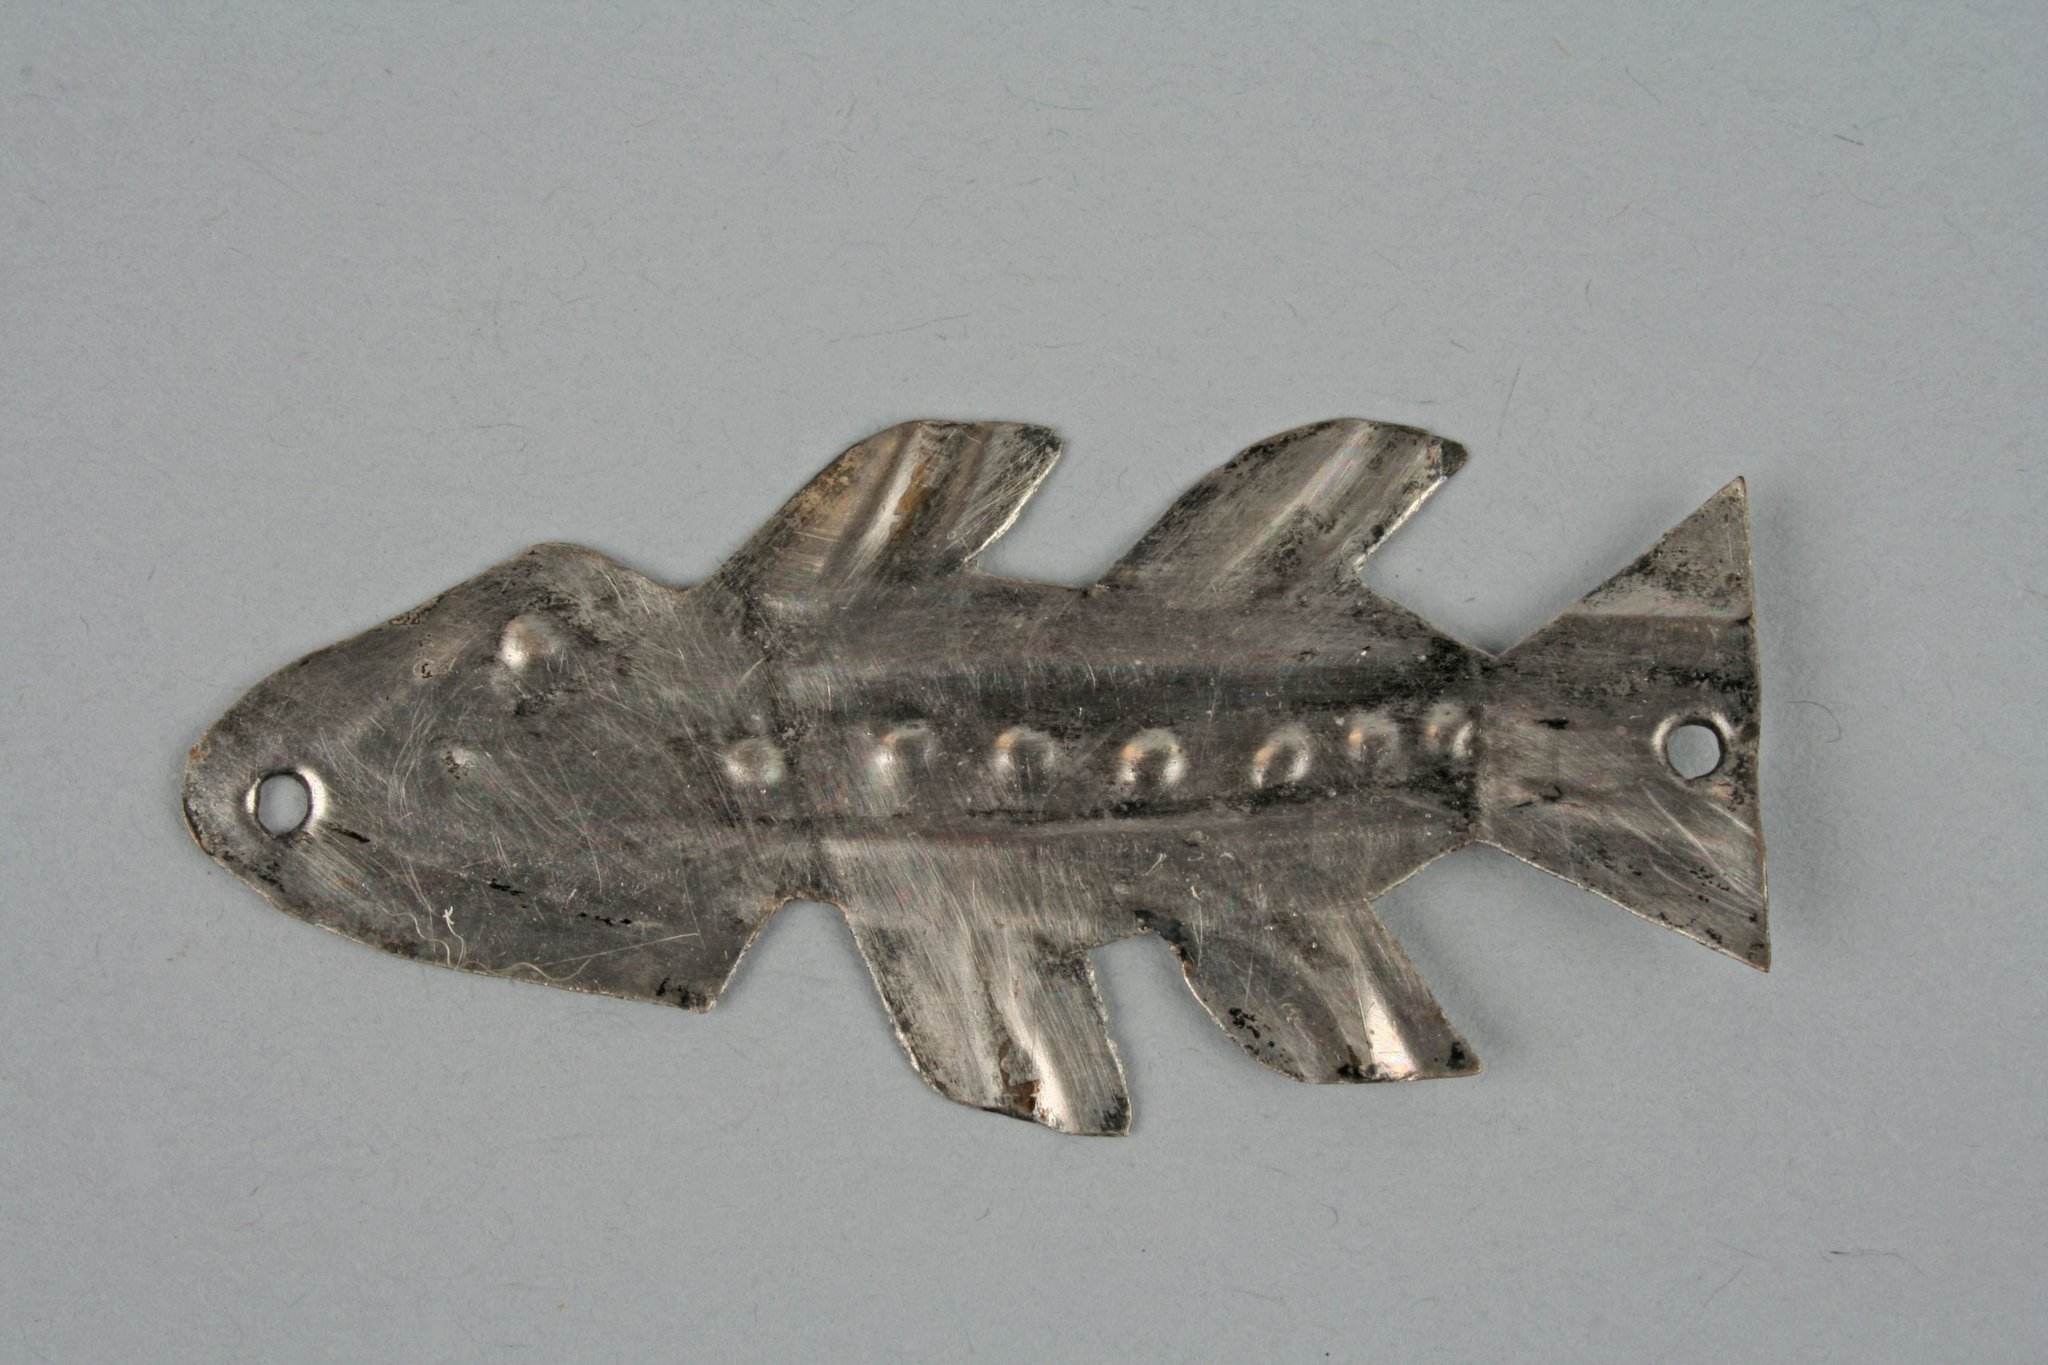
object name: ornament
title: Textile Ornament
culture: chimú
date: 1301-1500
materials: silver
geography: peru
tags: fish